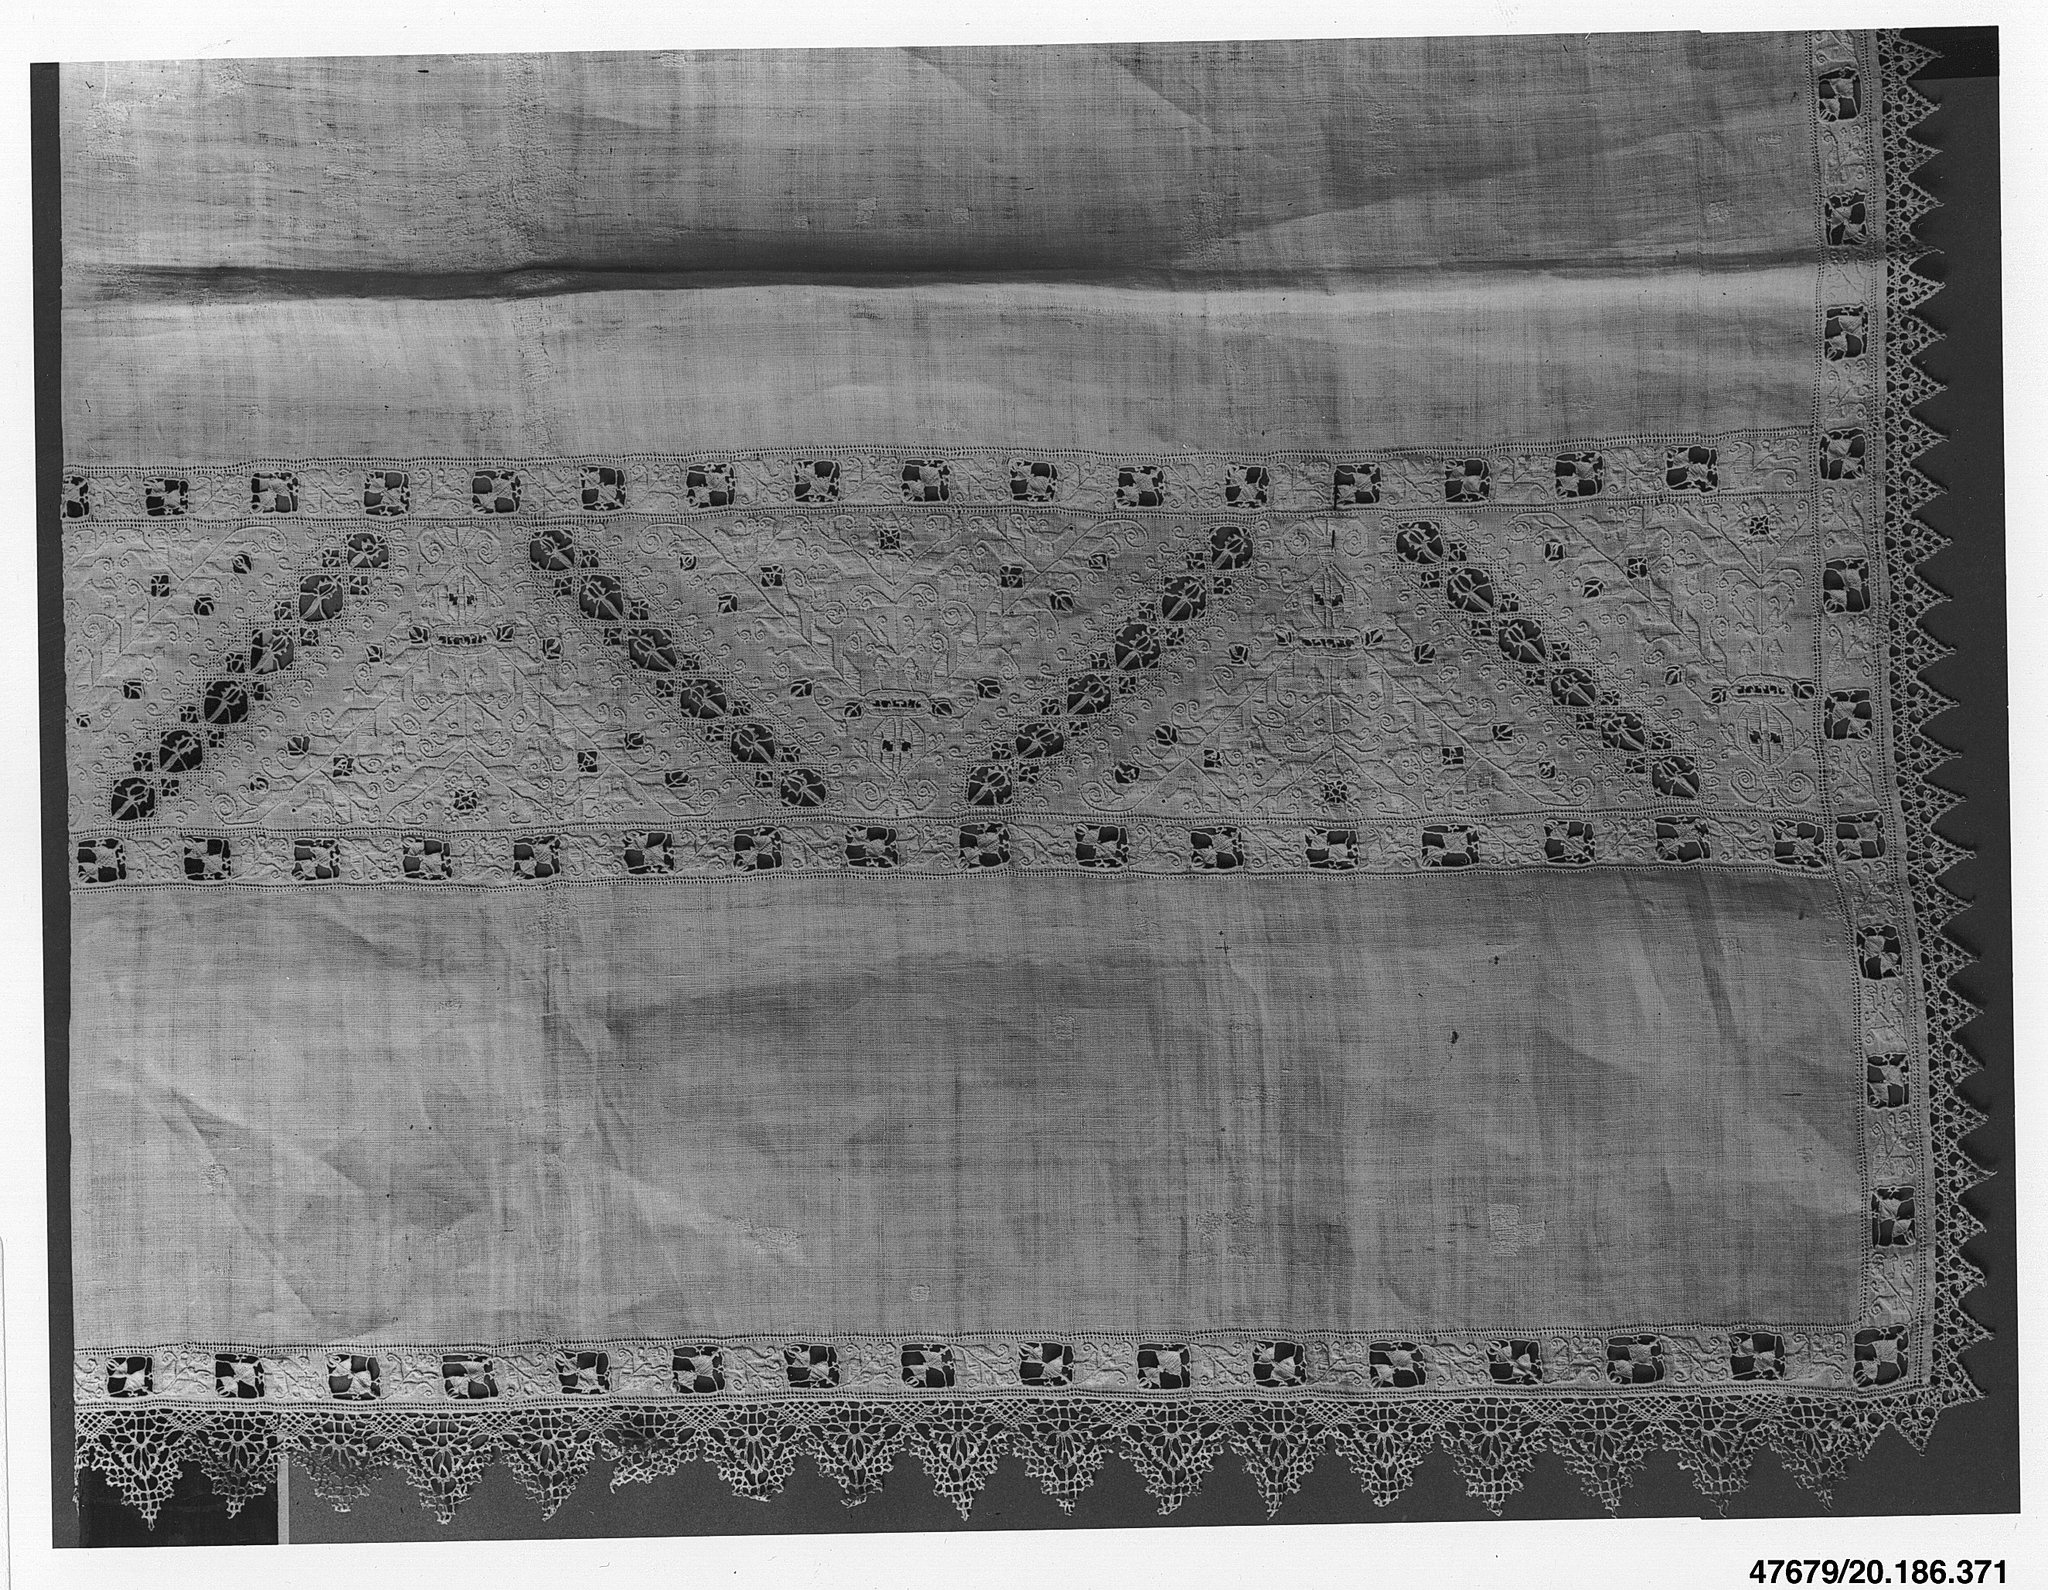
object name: altar cloth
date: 1600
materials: linen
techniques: embroidery